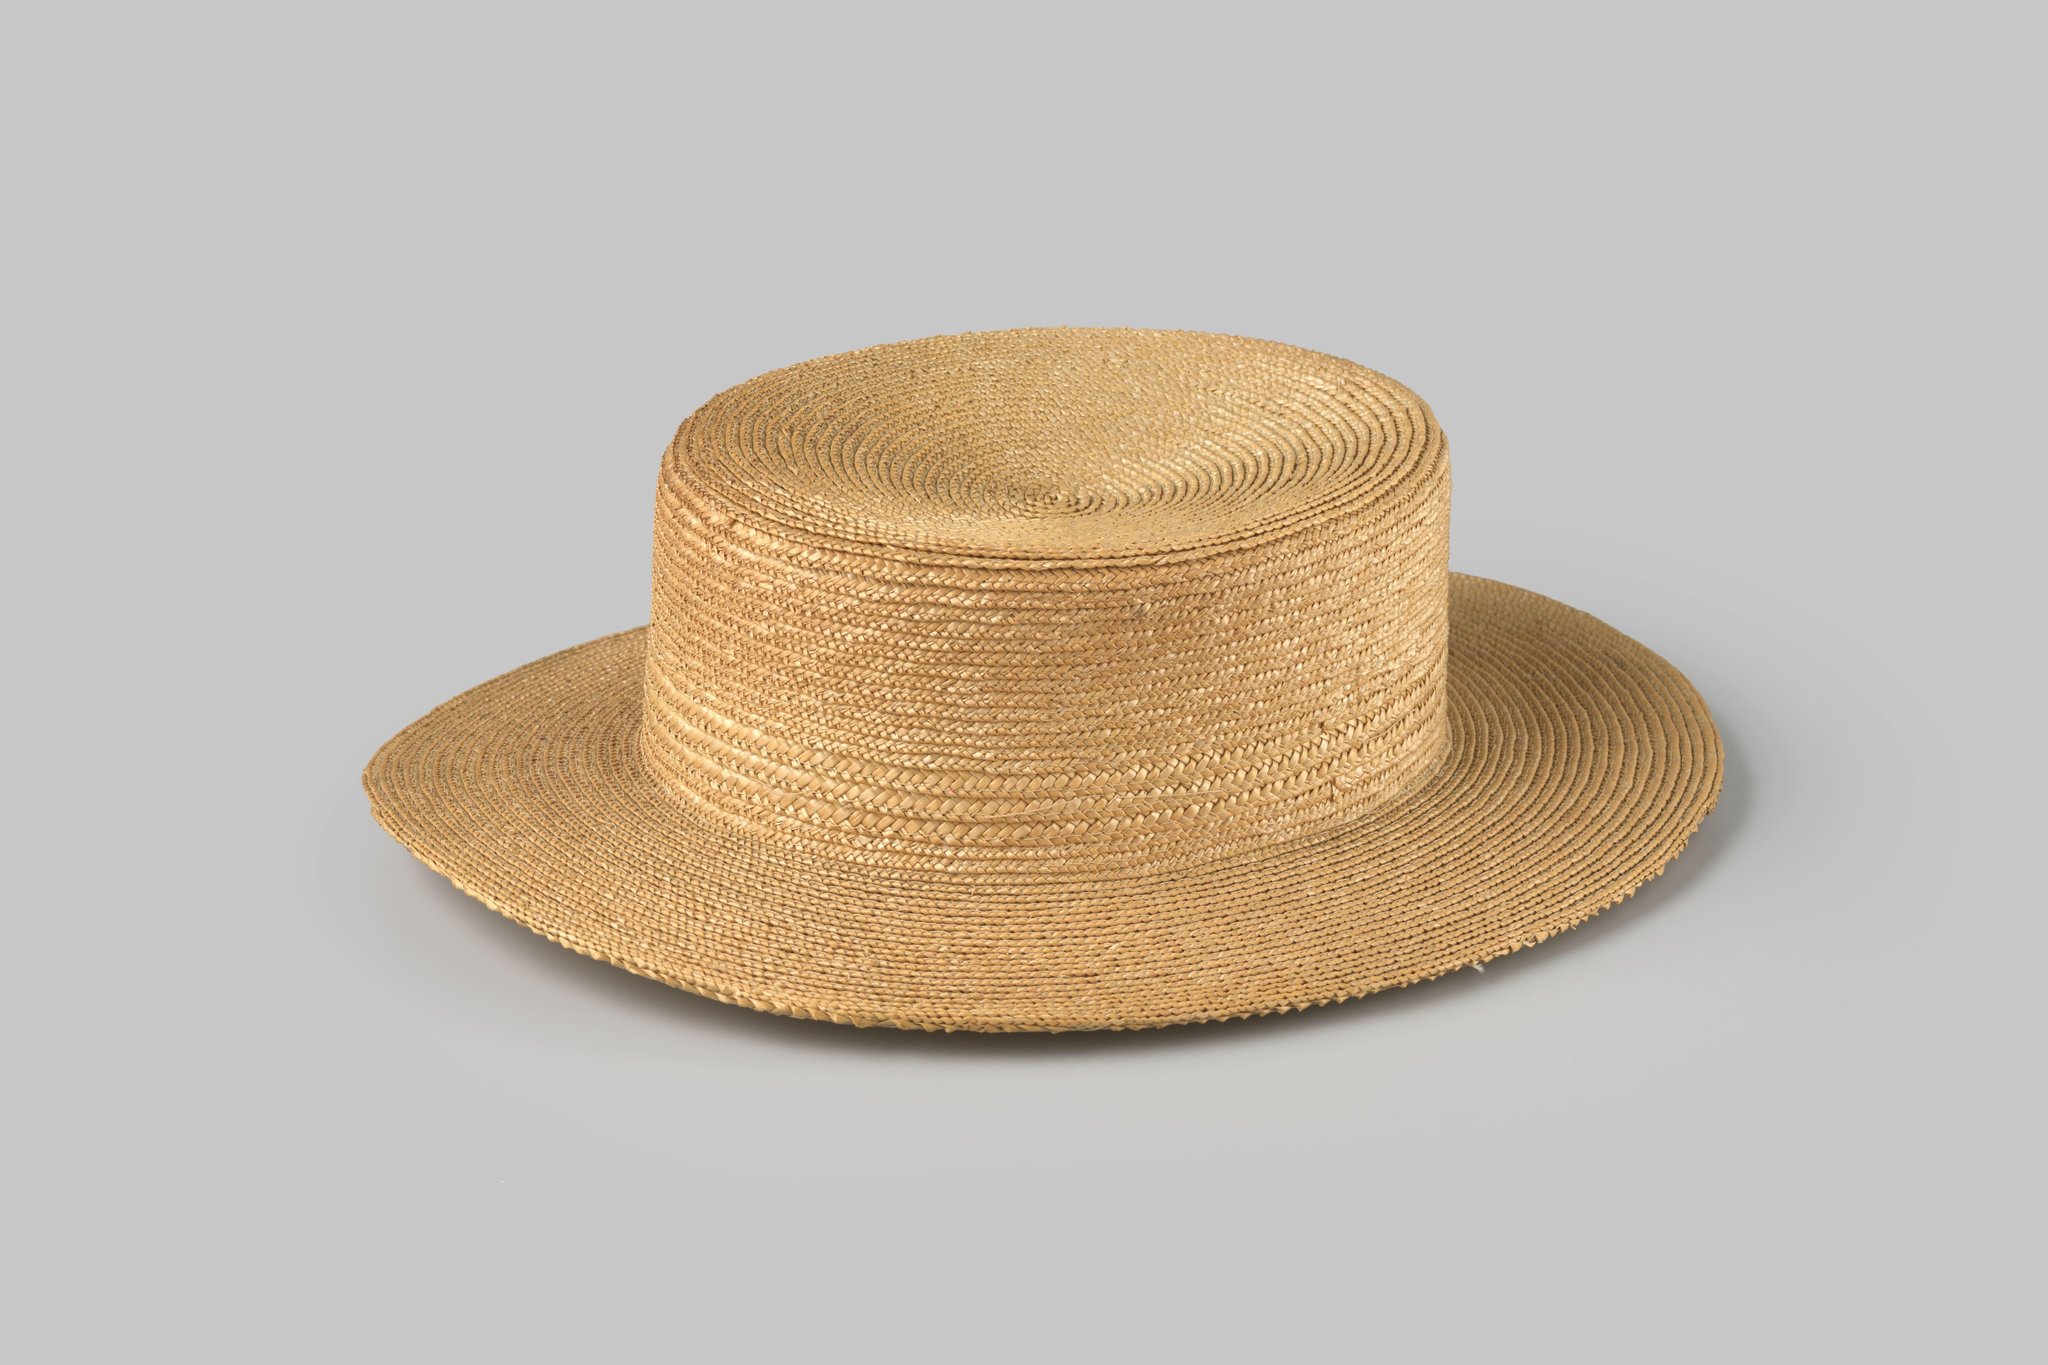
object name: menswear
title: Hoed van genaaid naturelkleurig bandstro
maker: Anonymous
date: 1900-1930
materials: straw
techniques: strohalm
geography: france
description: Hoed van genaaid naturelkleurig bandstro. Zonder lint. Ovaal, plat. Verdubbelde rand van breed bandstro, waarin gladde driehoekjes.